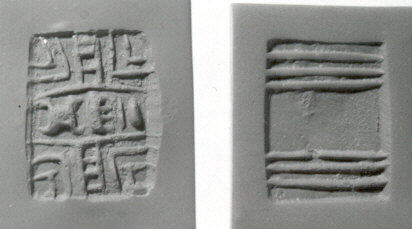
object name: stamp seal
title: Rectangular plaque seal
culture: egyptian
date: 1479-1425 BCE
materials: bone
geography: egypt